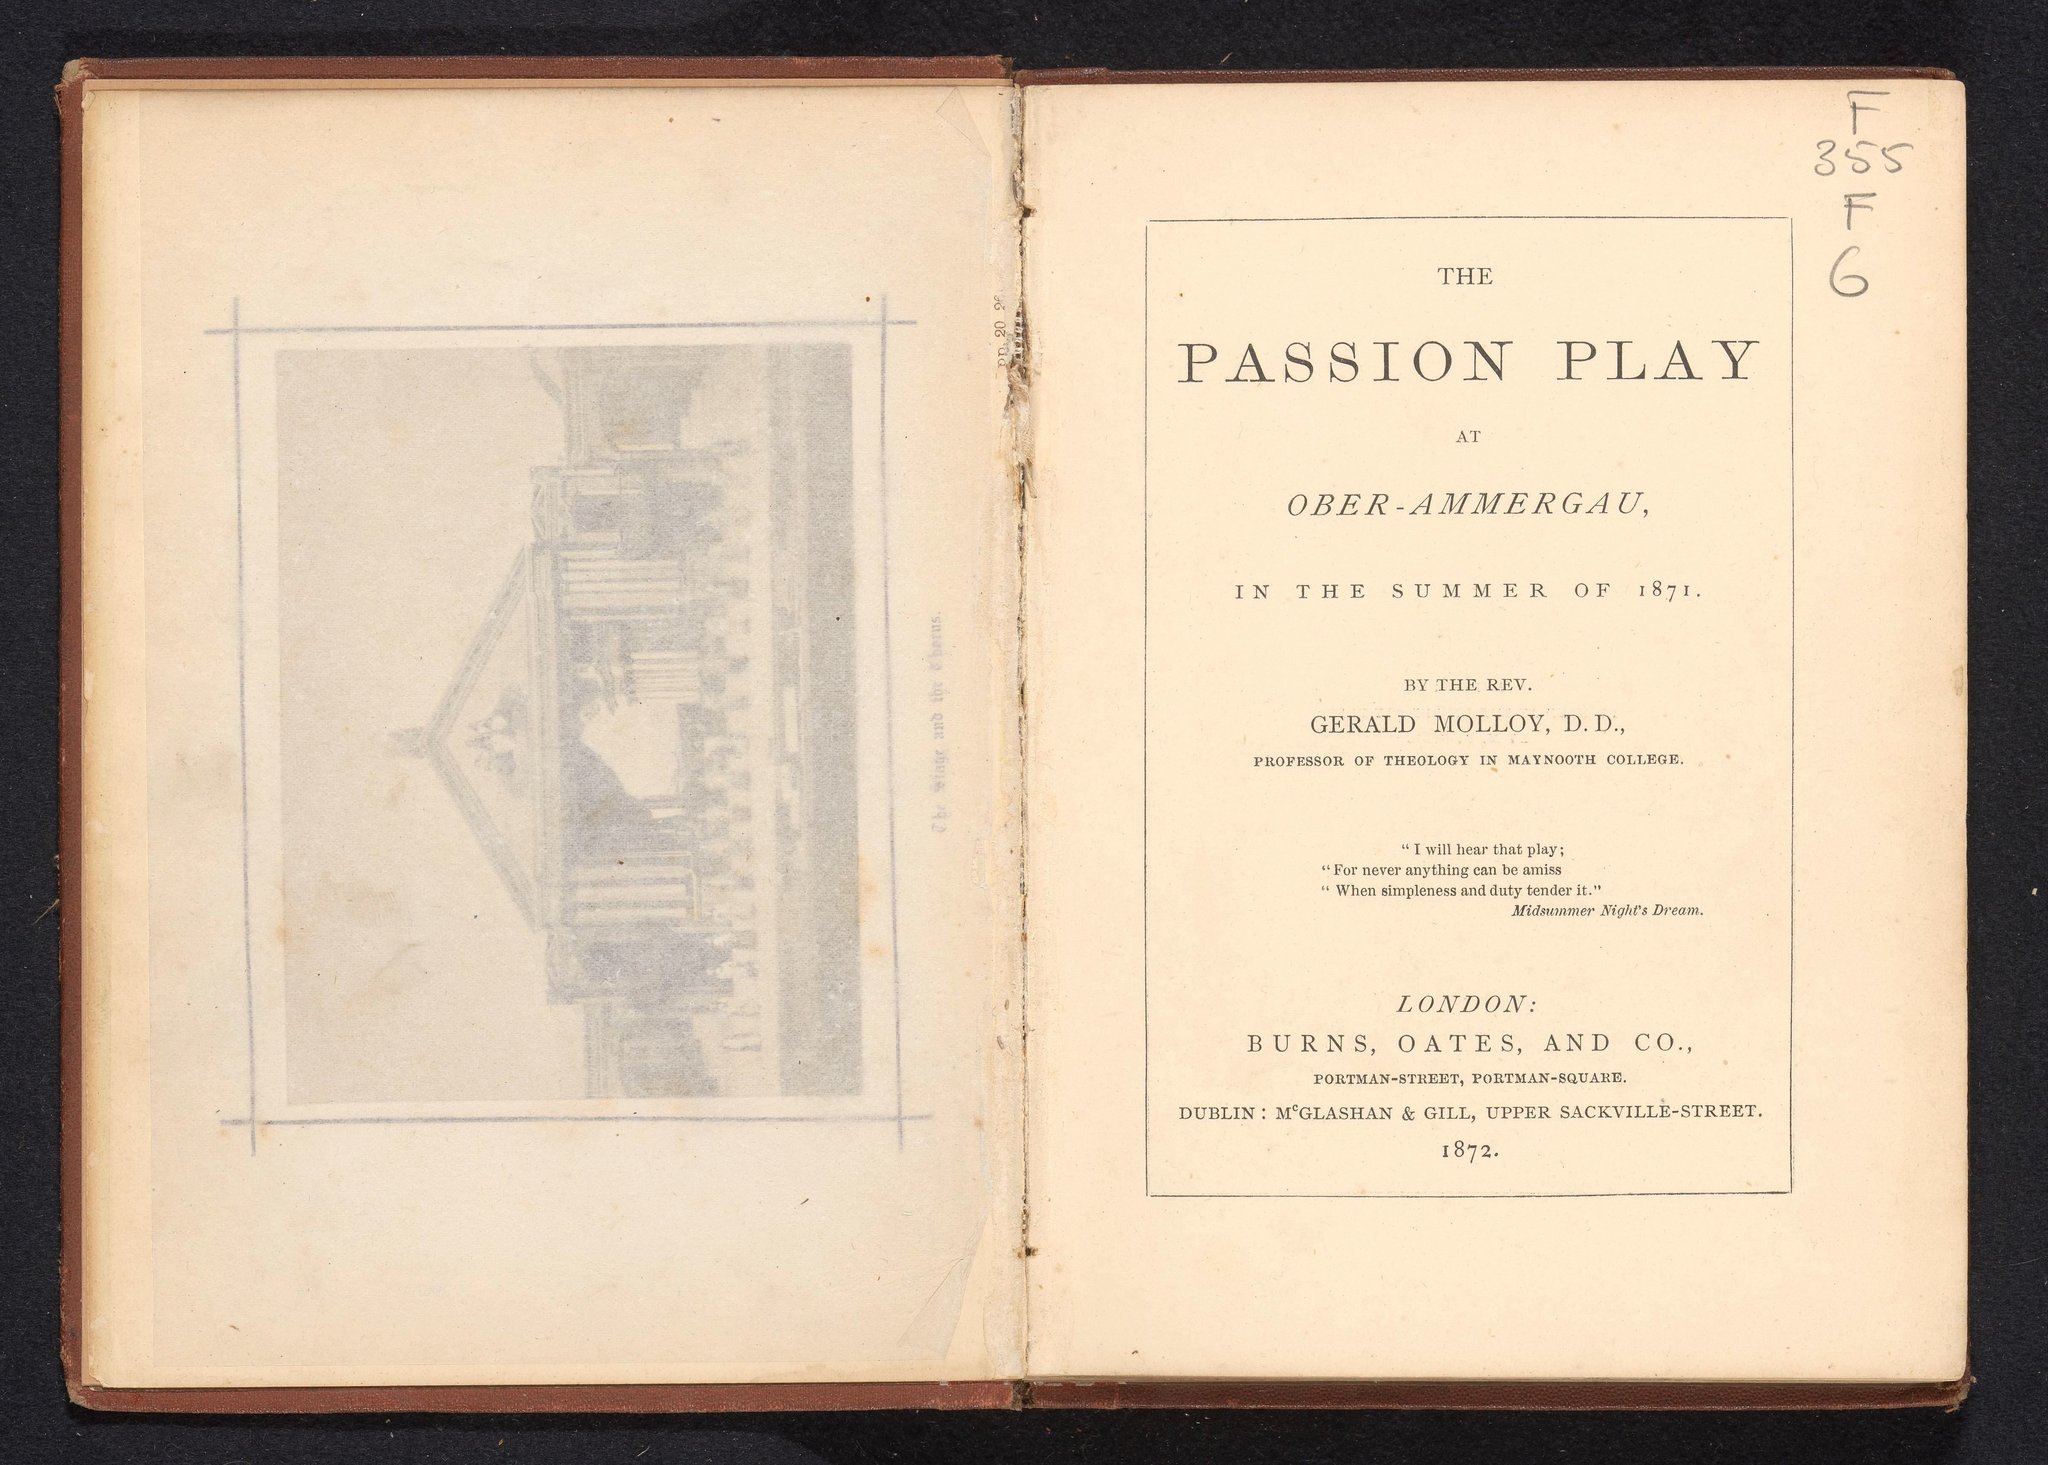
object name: book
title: The Passion Play at Ober-Ammergau in the summer of 1871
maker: gerald molloy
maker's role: clergyman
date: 1872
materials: cardboard, linen, paper, photographic support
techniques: albumen print, printing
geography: london